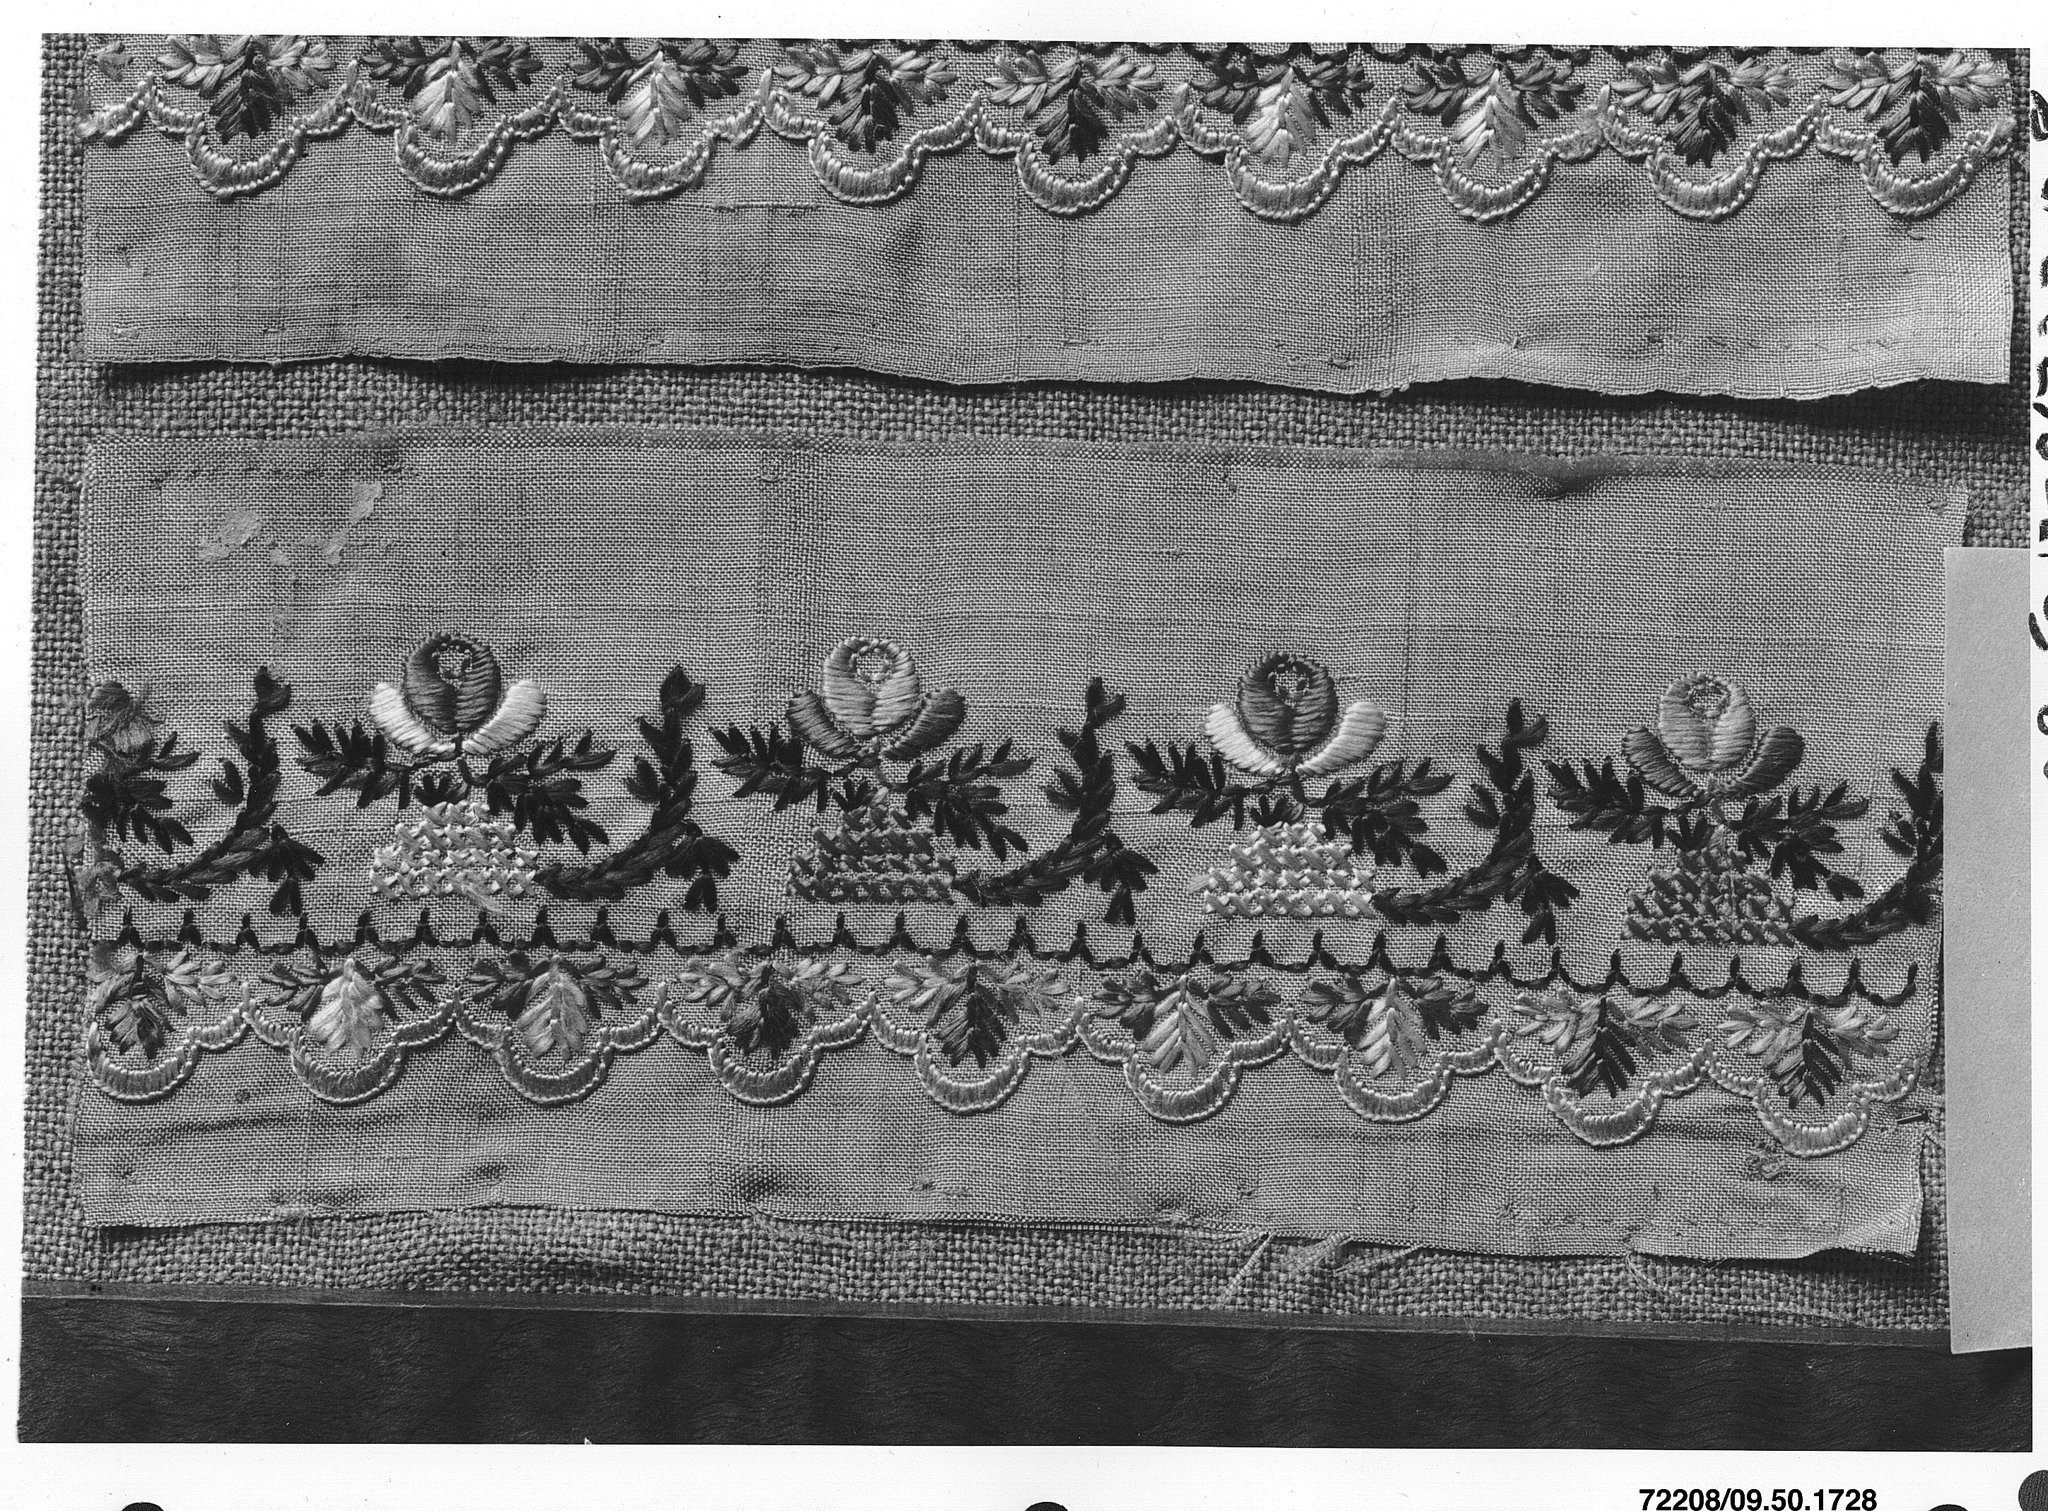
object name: fragment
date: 1801-1900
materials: silk